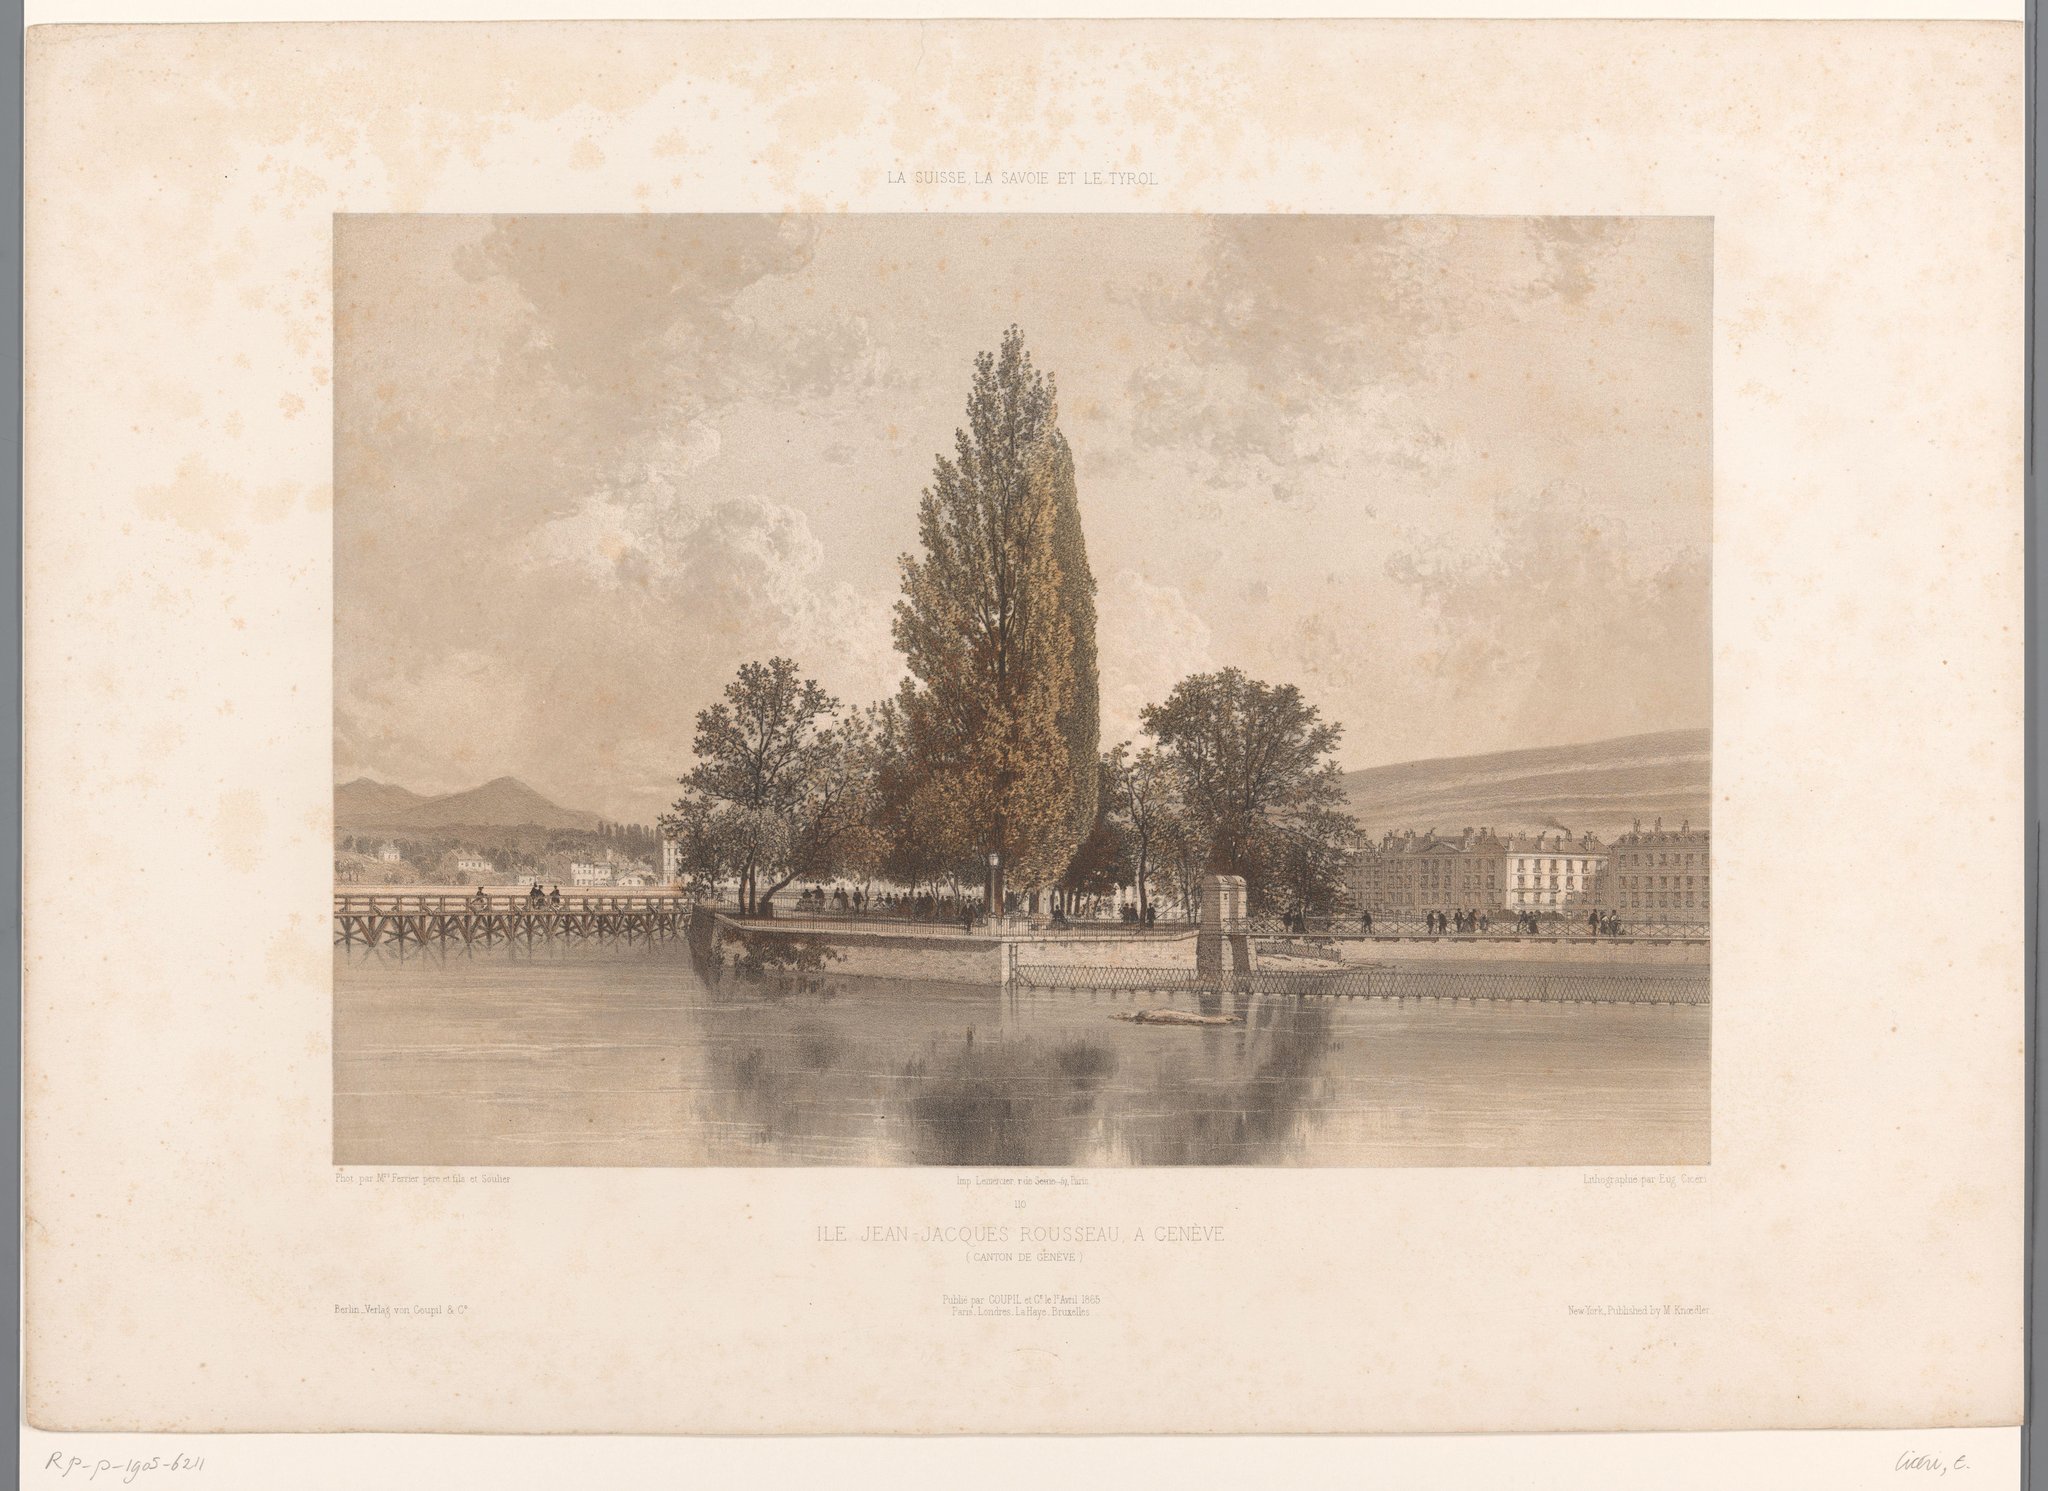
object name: print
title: Île Jean-Jacques Rousseau à Genève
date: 1859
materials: paper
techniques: lithograph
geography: paris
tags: island, bridge in city across river, canal, etc. (+ city(-scape) with figures, staffage)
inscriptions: collector's mark: Lugt 2228a, check stamp: Lugt 1090